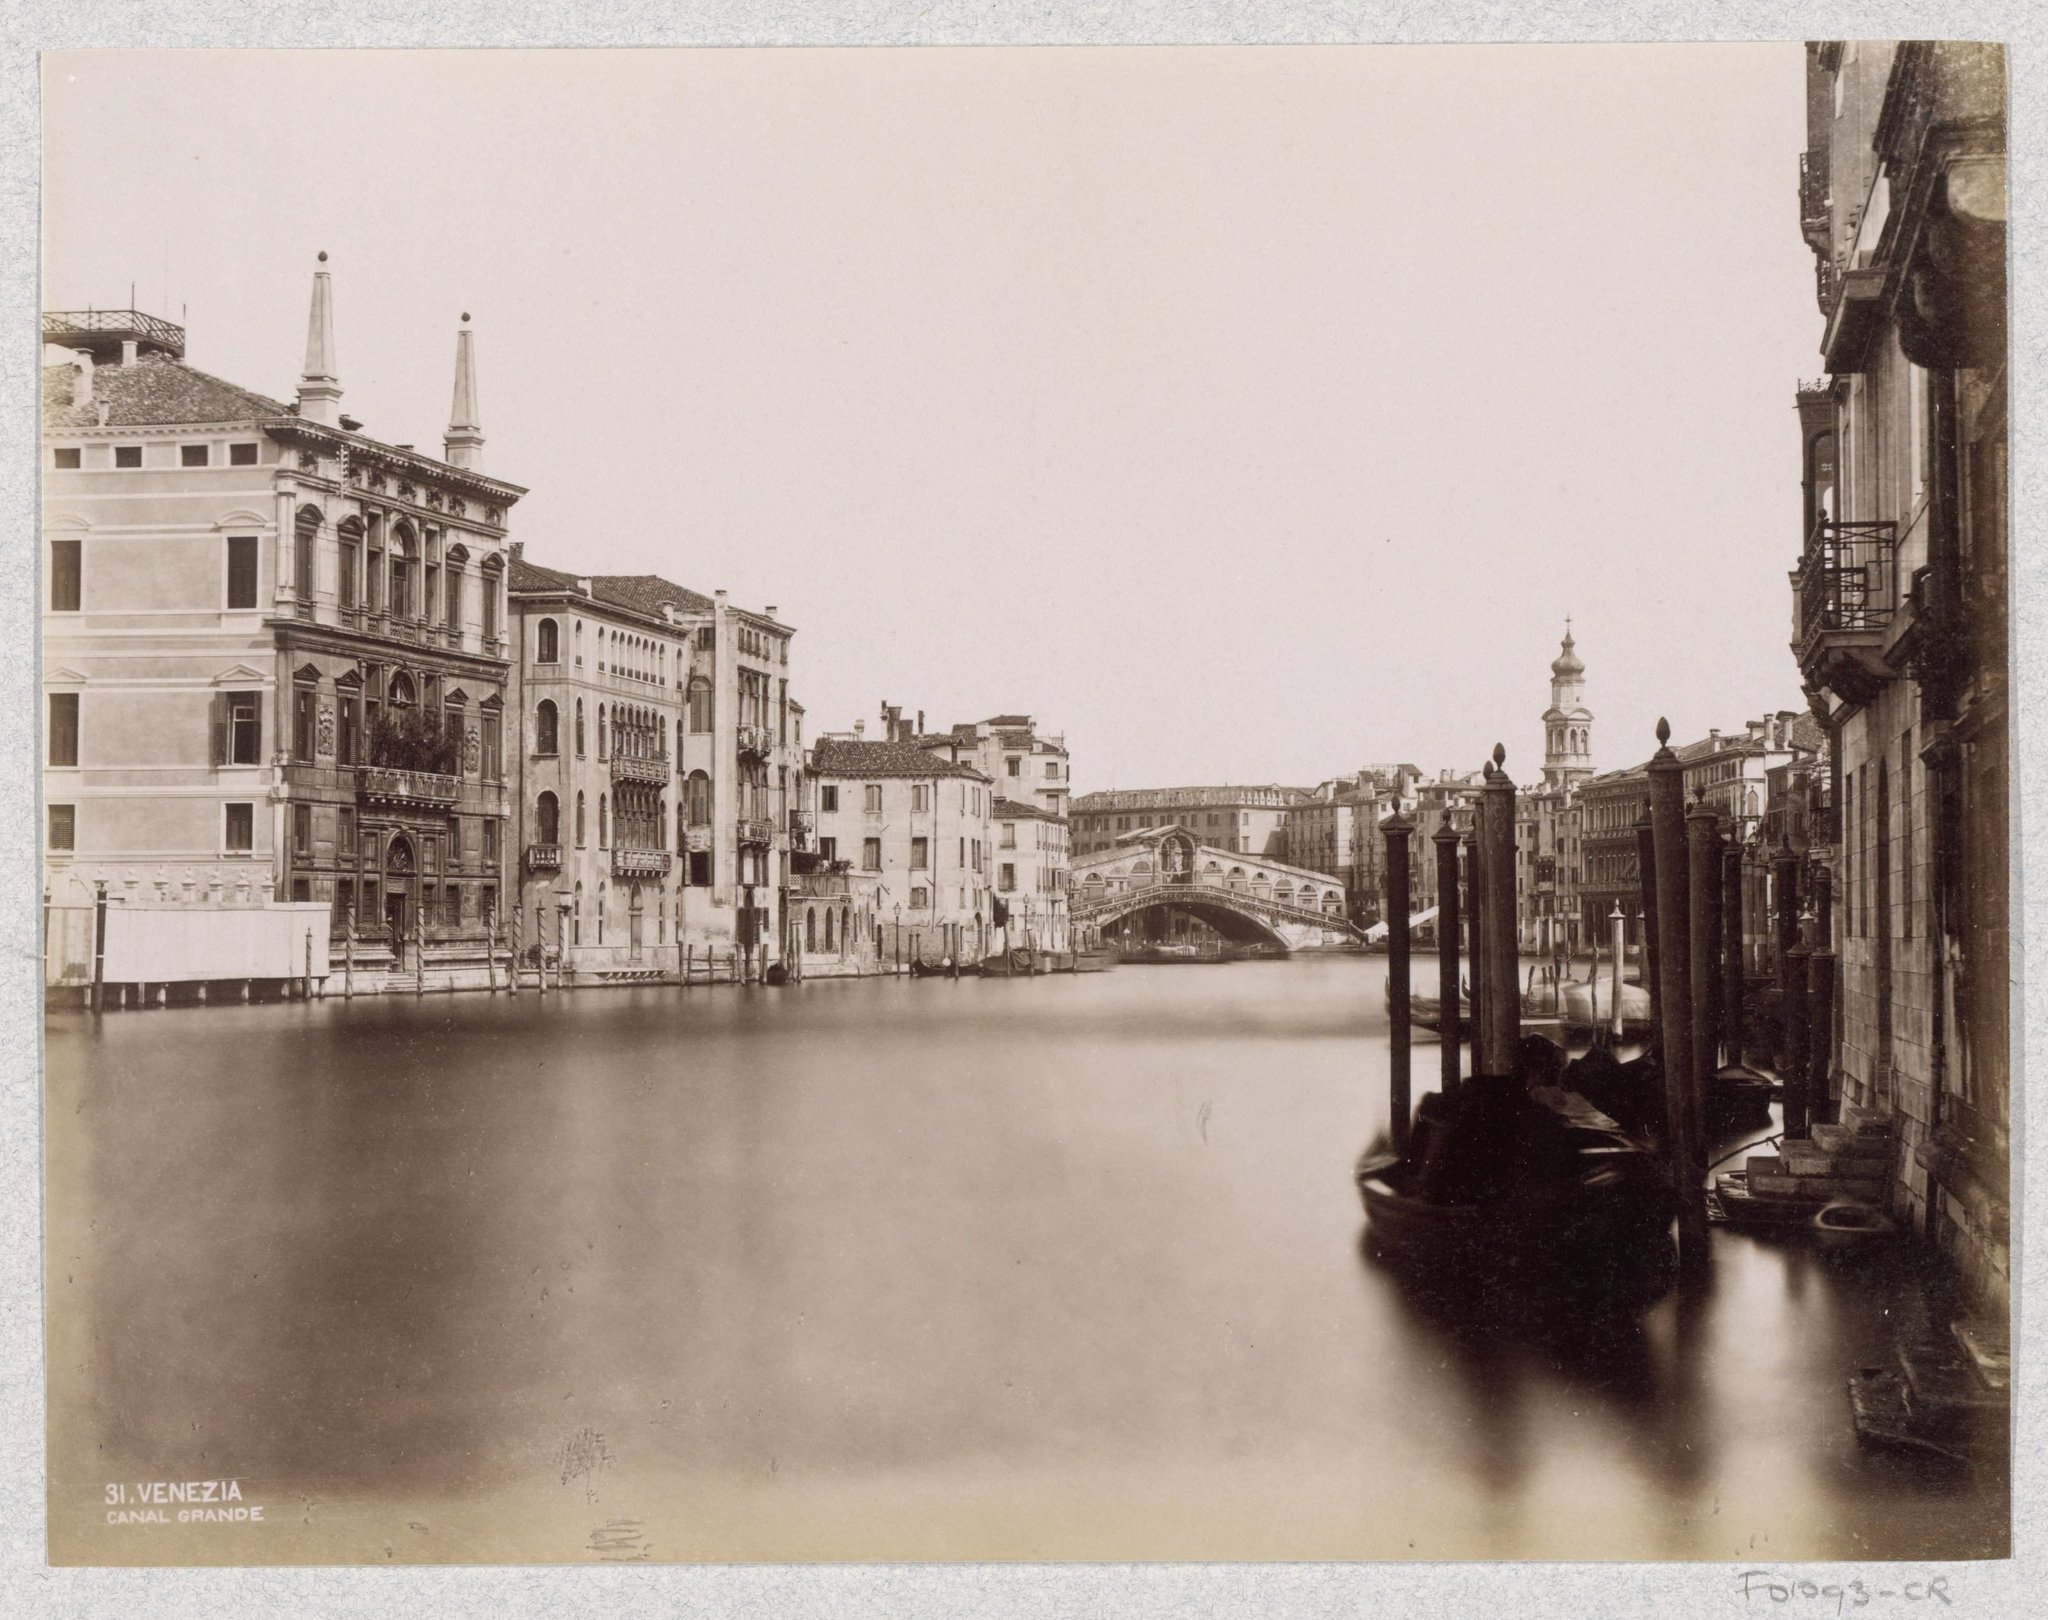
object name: photograph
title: Huizen aan het Canal Grande in Venetië en op de achtergrond de Rialtobrug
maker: Anonymous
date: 1870-1890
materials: paper, photographic support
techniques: albumen print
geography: venice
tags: canal, palace, bridge in city across river, canal, etc., venice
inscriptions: negative number: ‘31’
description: Onderdeel van Reisalbum met foto's van bezienswaardigheden in Genua, Florence en Venetië.